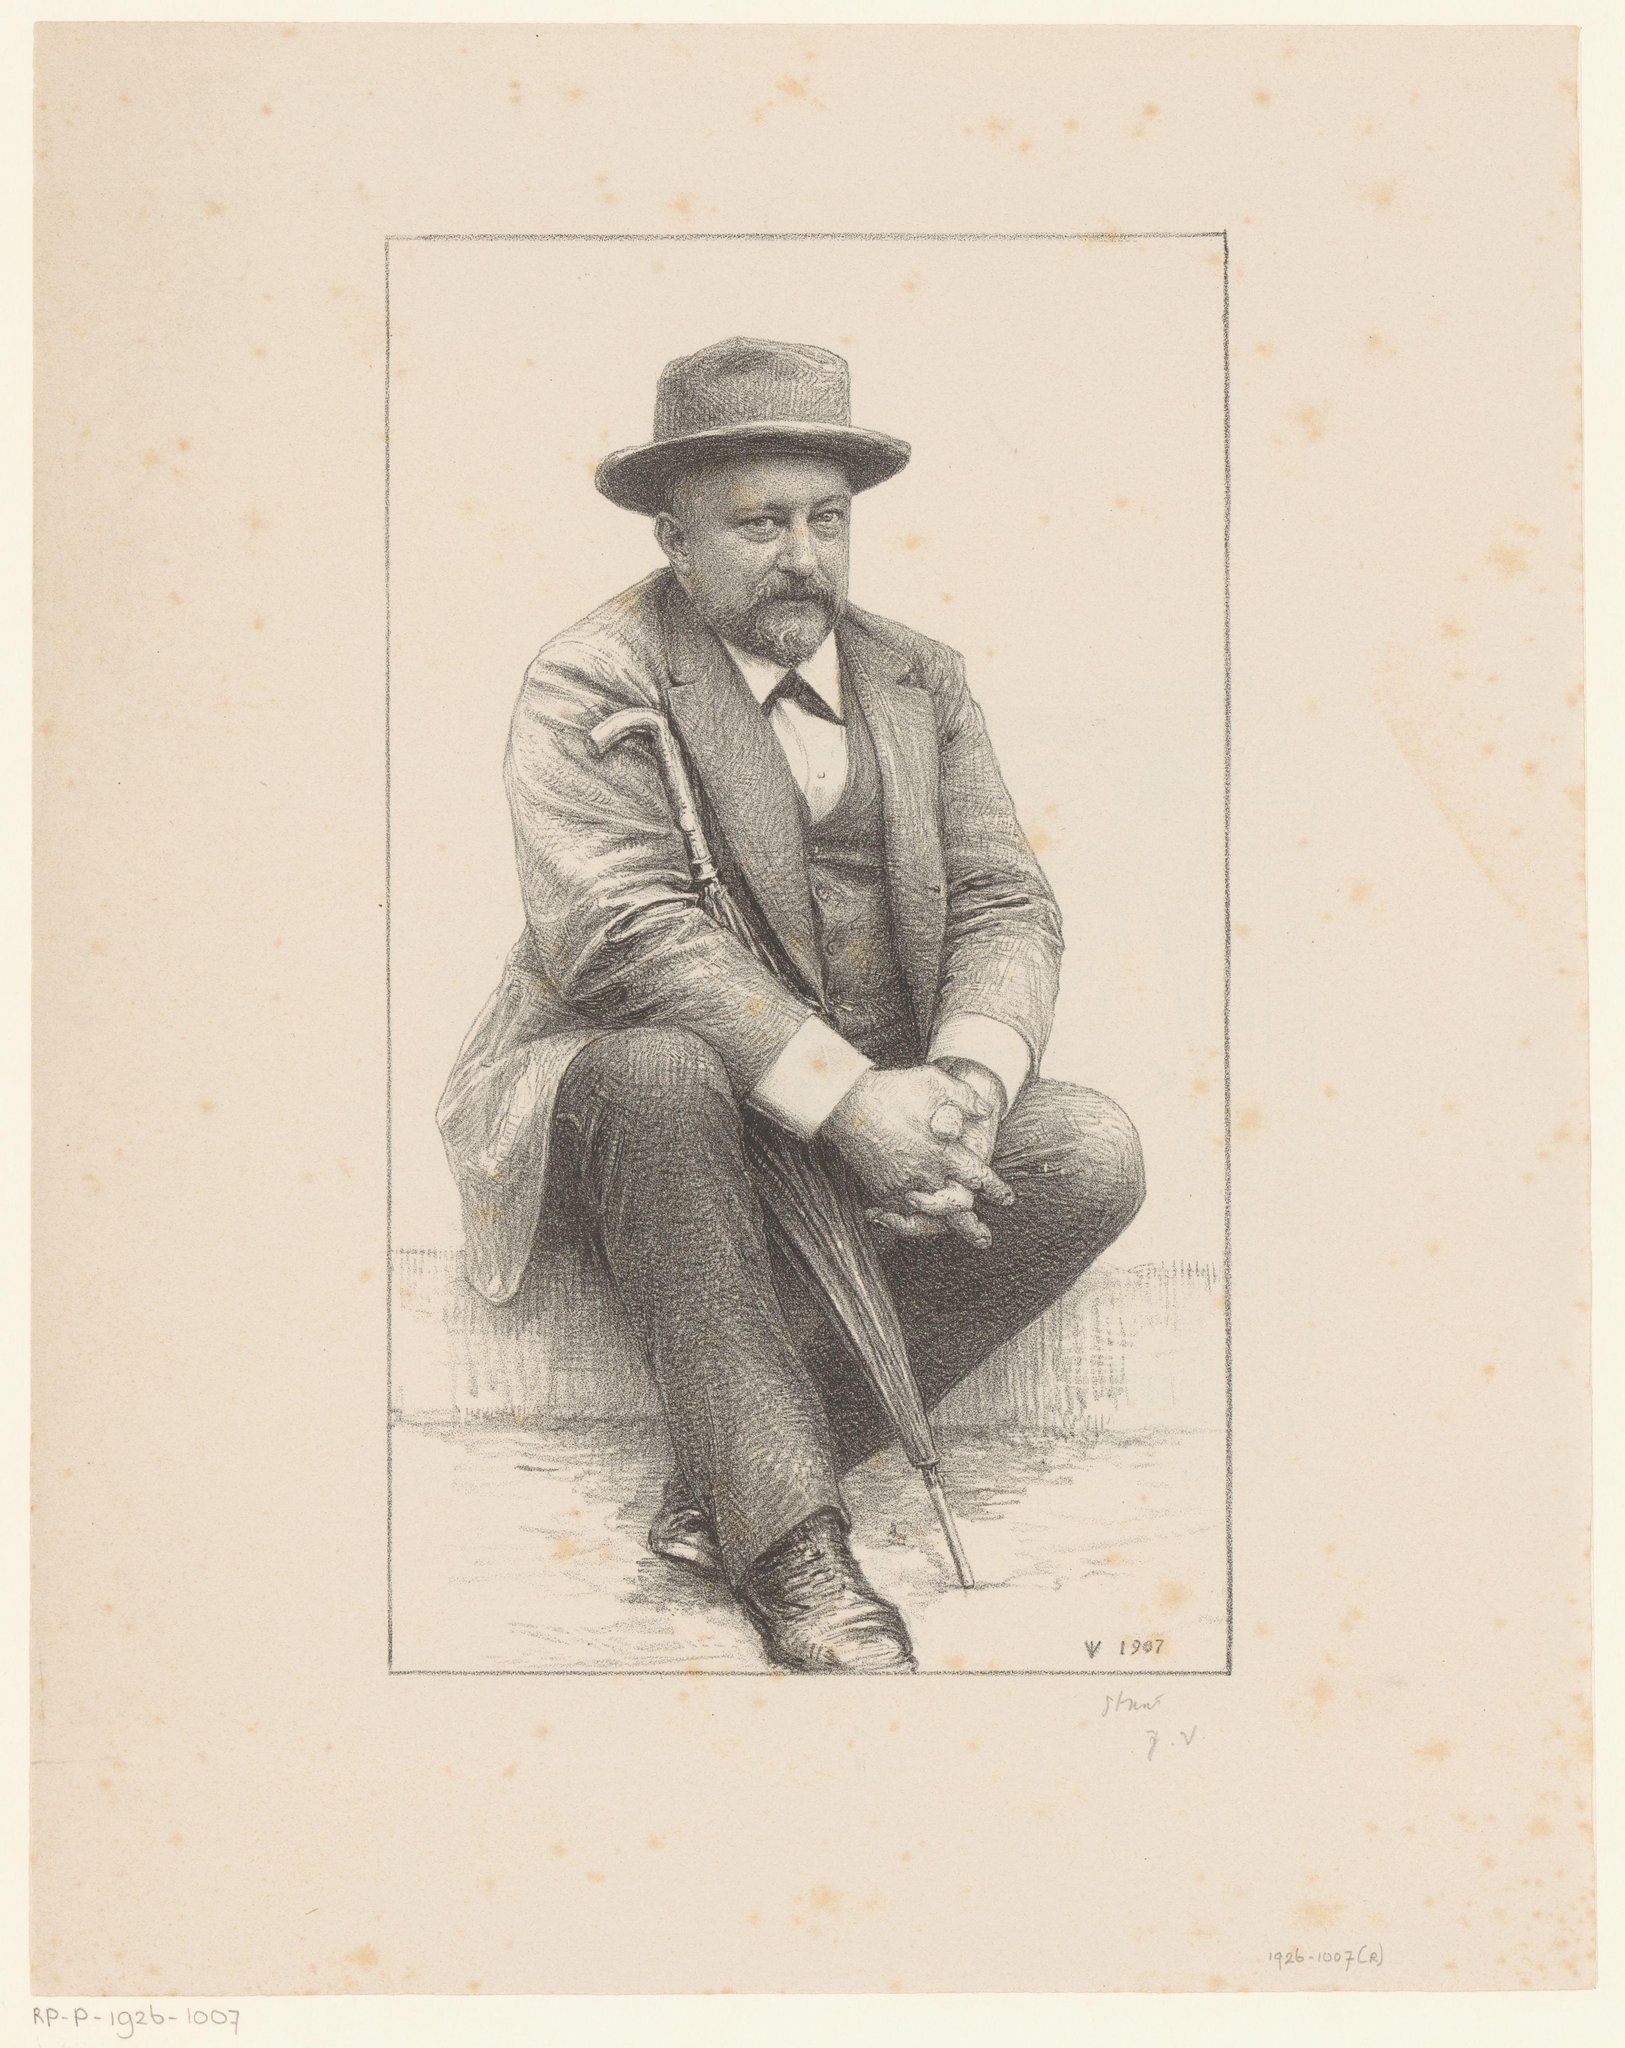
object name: print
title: Portret van Pieter Lodewijk Tak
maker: jan veth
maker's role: designer, draughtsman, painter, print maker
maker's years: 1864-1925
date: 1907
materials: paper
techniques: lithograph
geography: netherlands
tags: pieter lodewijk tak, historical persons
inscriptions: inscription: ‘staat / J.V.’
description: Dit portret werd uitgegeven als bijvoegsel bij De Kroniek op 19 oktober 1907.